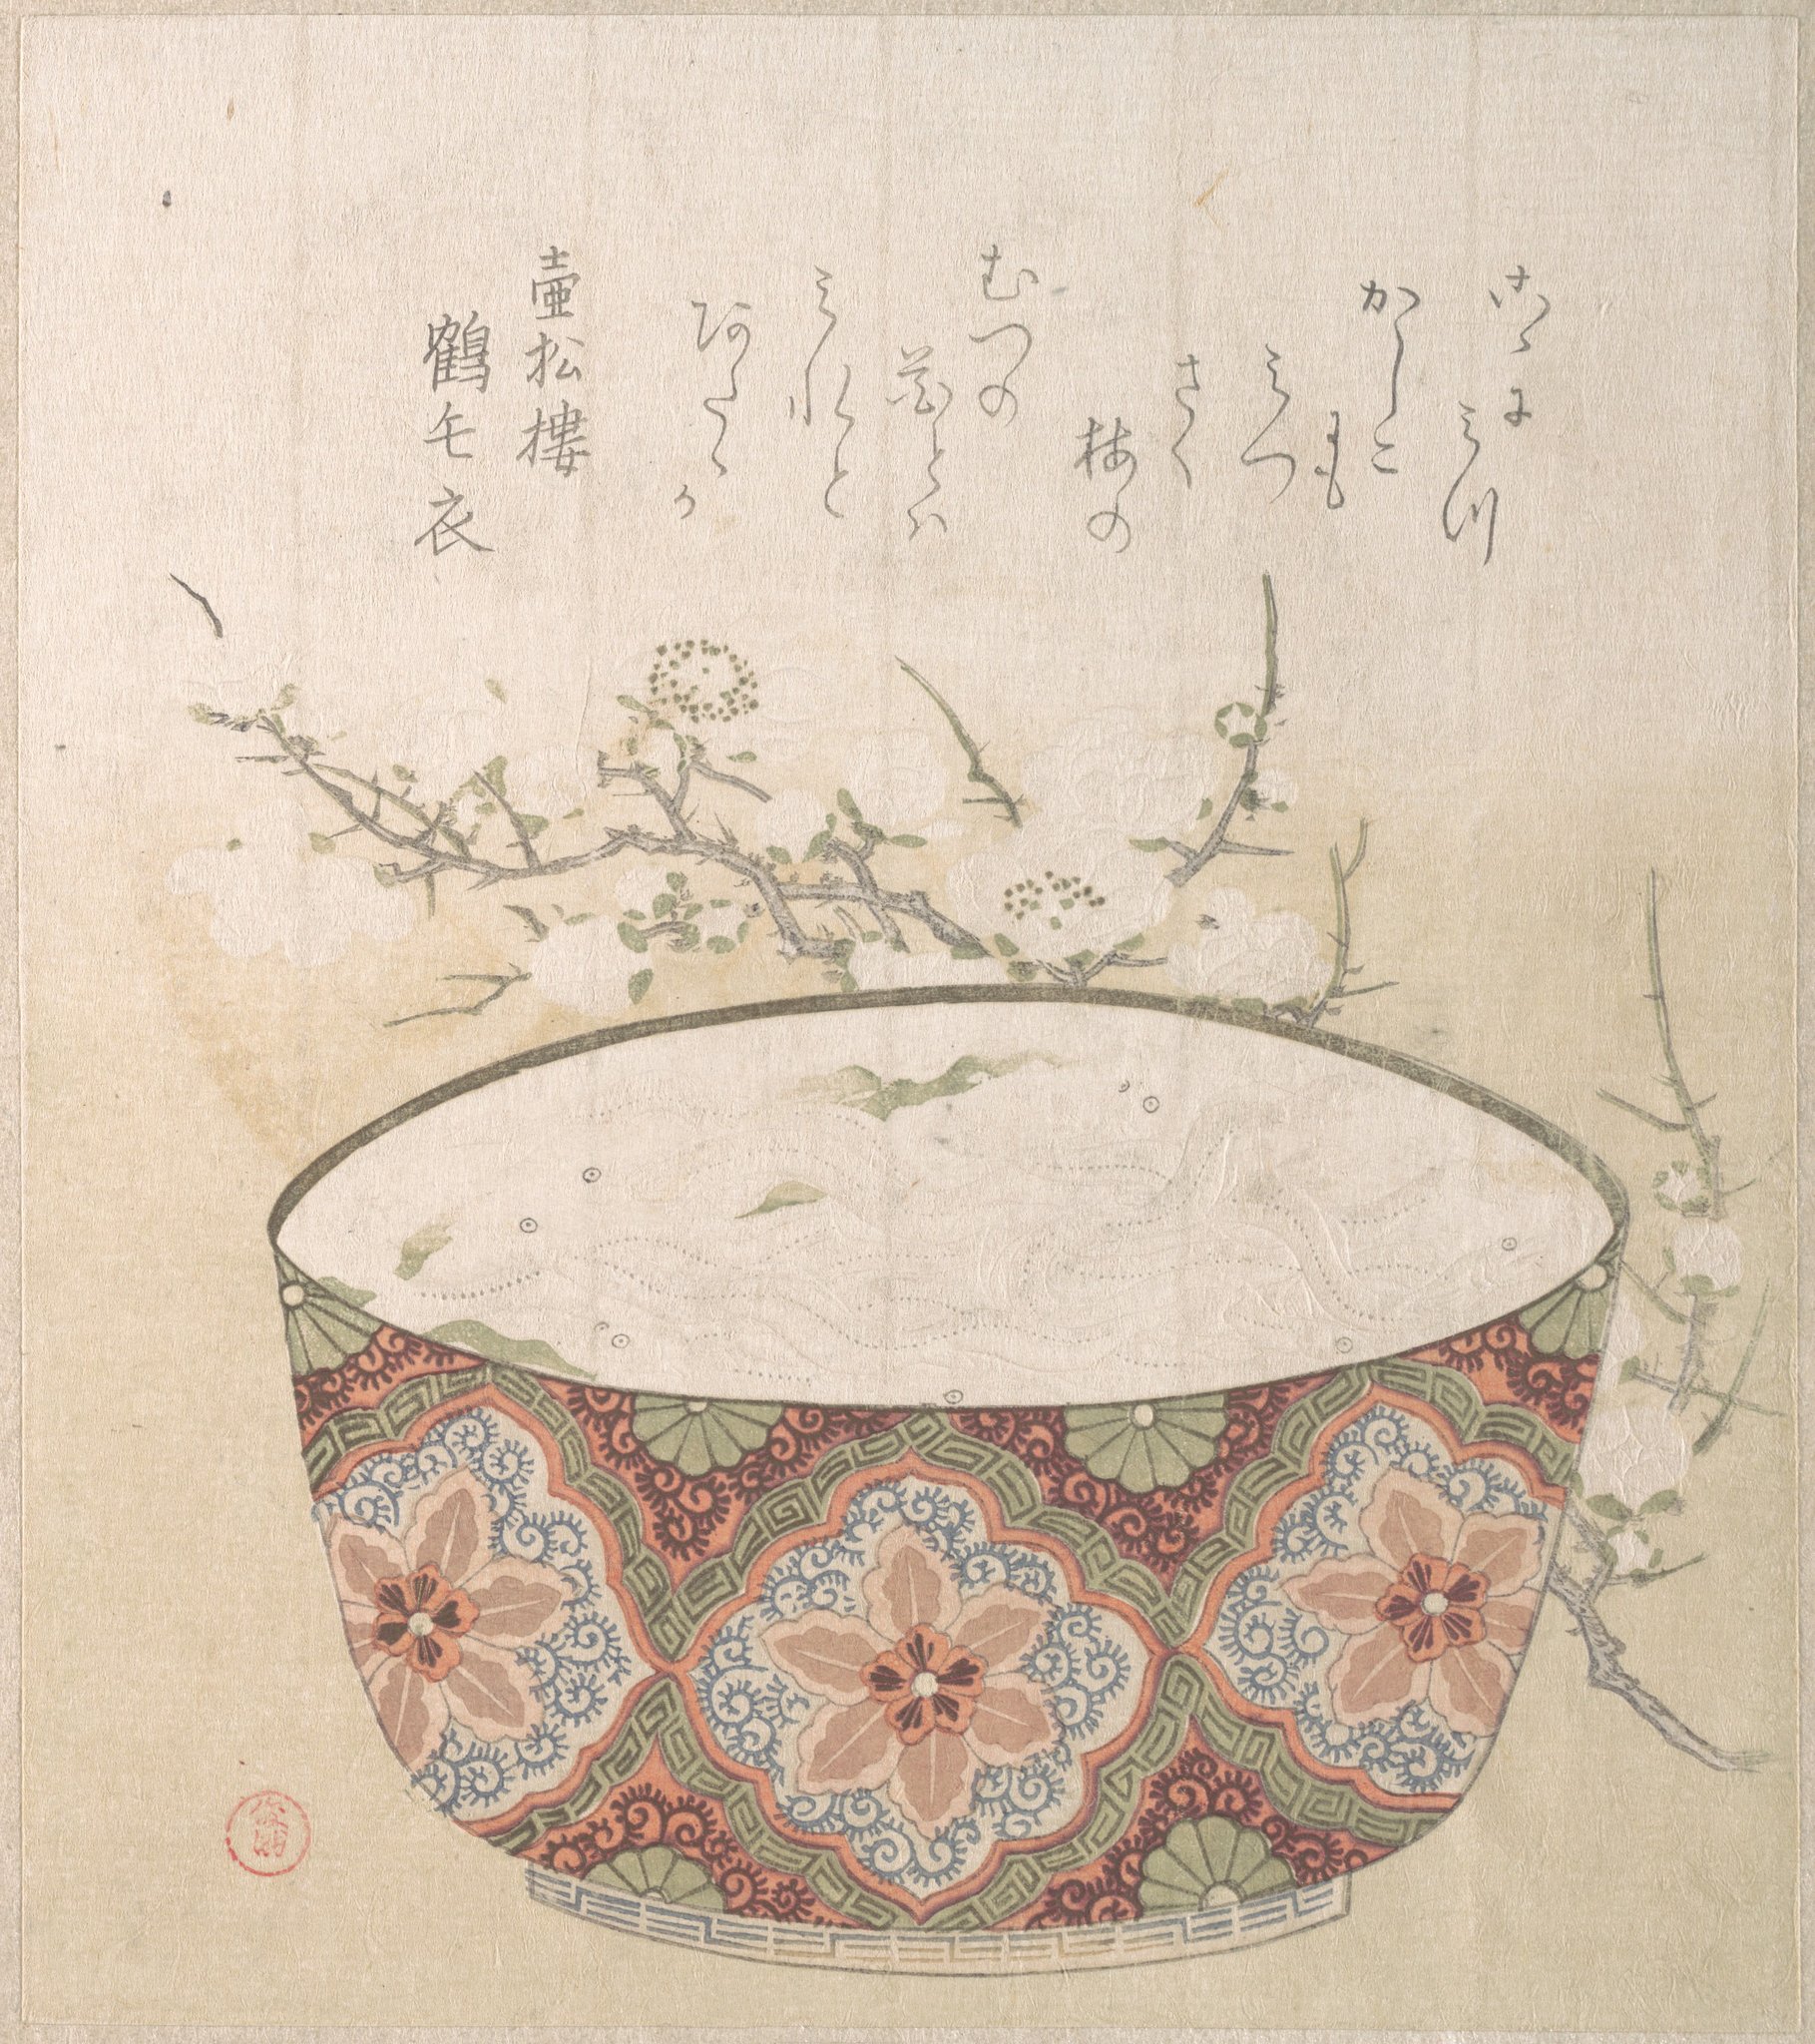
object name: woodblock print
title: Bowl with White-Baits and Plum Blossoms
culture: japanese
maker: kubo shunman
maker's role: artist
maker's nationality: japanese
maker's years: 1757-1820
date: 1801-1900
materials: ink, paper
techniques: surimono, woodblock print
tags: flowers